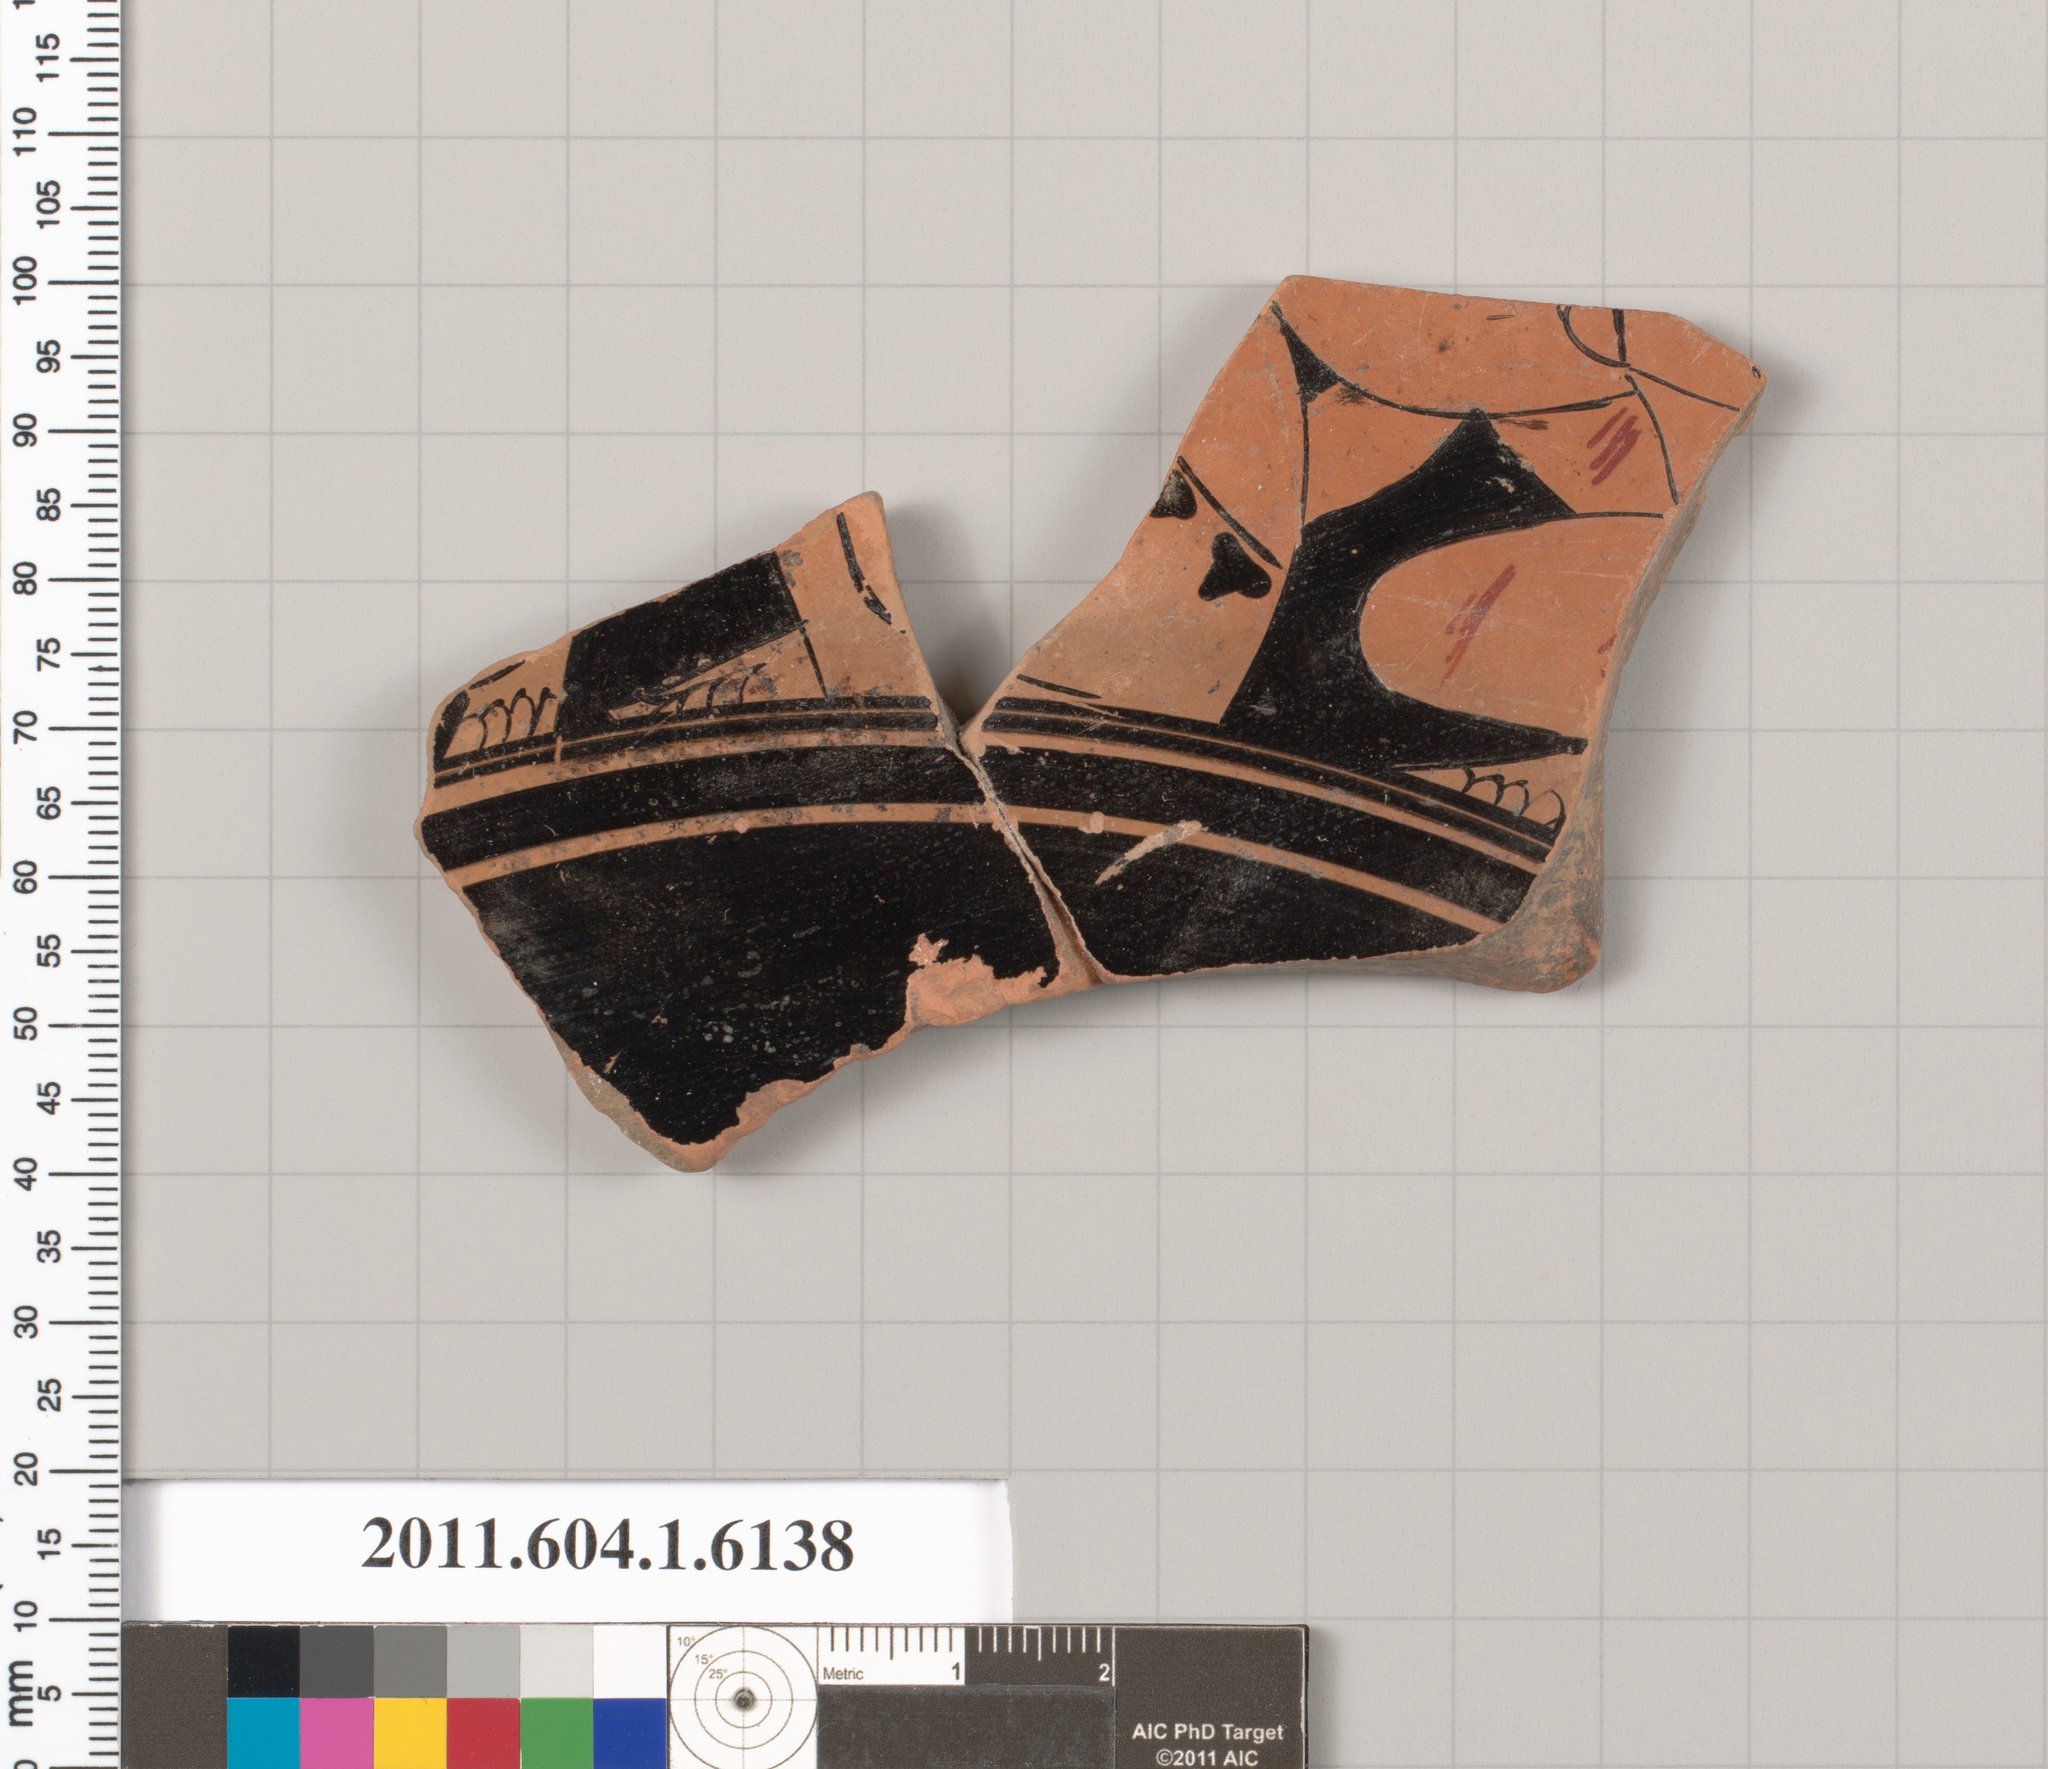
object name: kylix fragment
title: Terracotta fragment of a kylix (drinking cup)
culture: greek, attic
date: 520-500 BCE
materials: terracotta